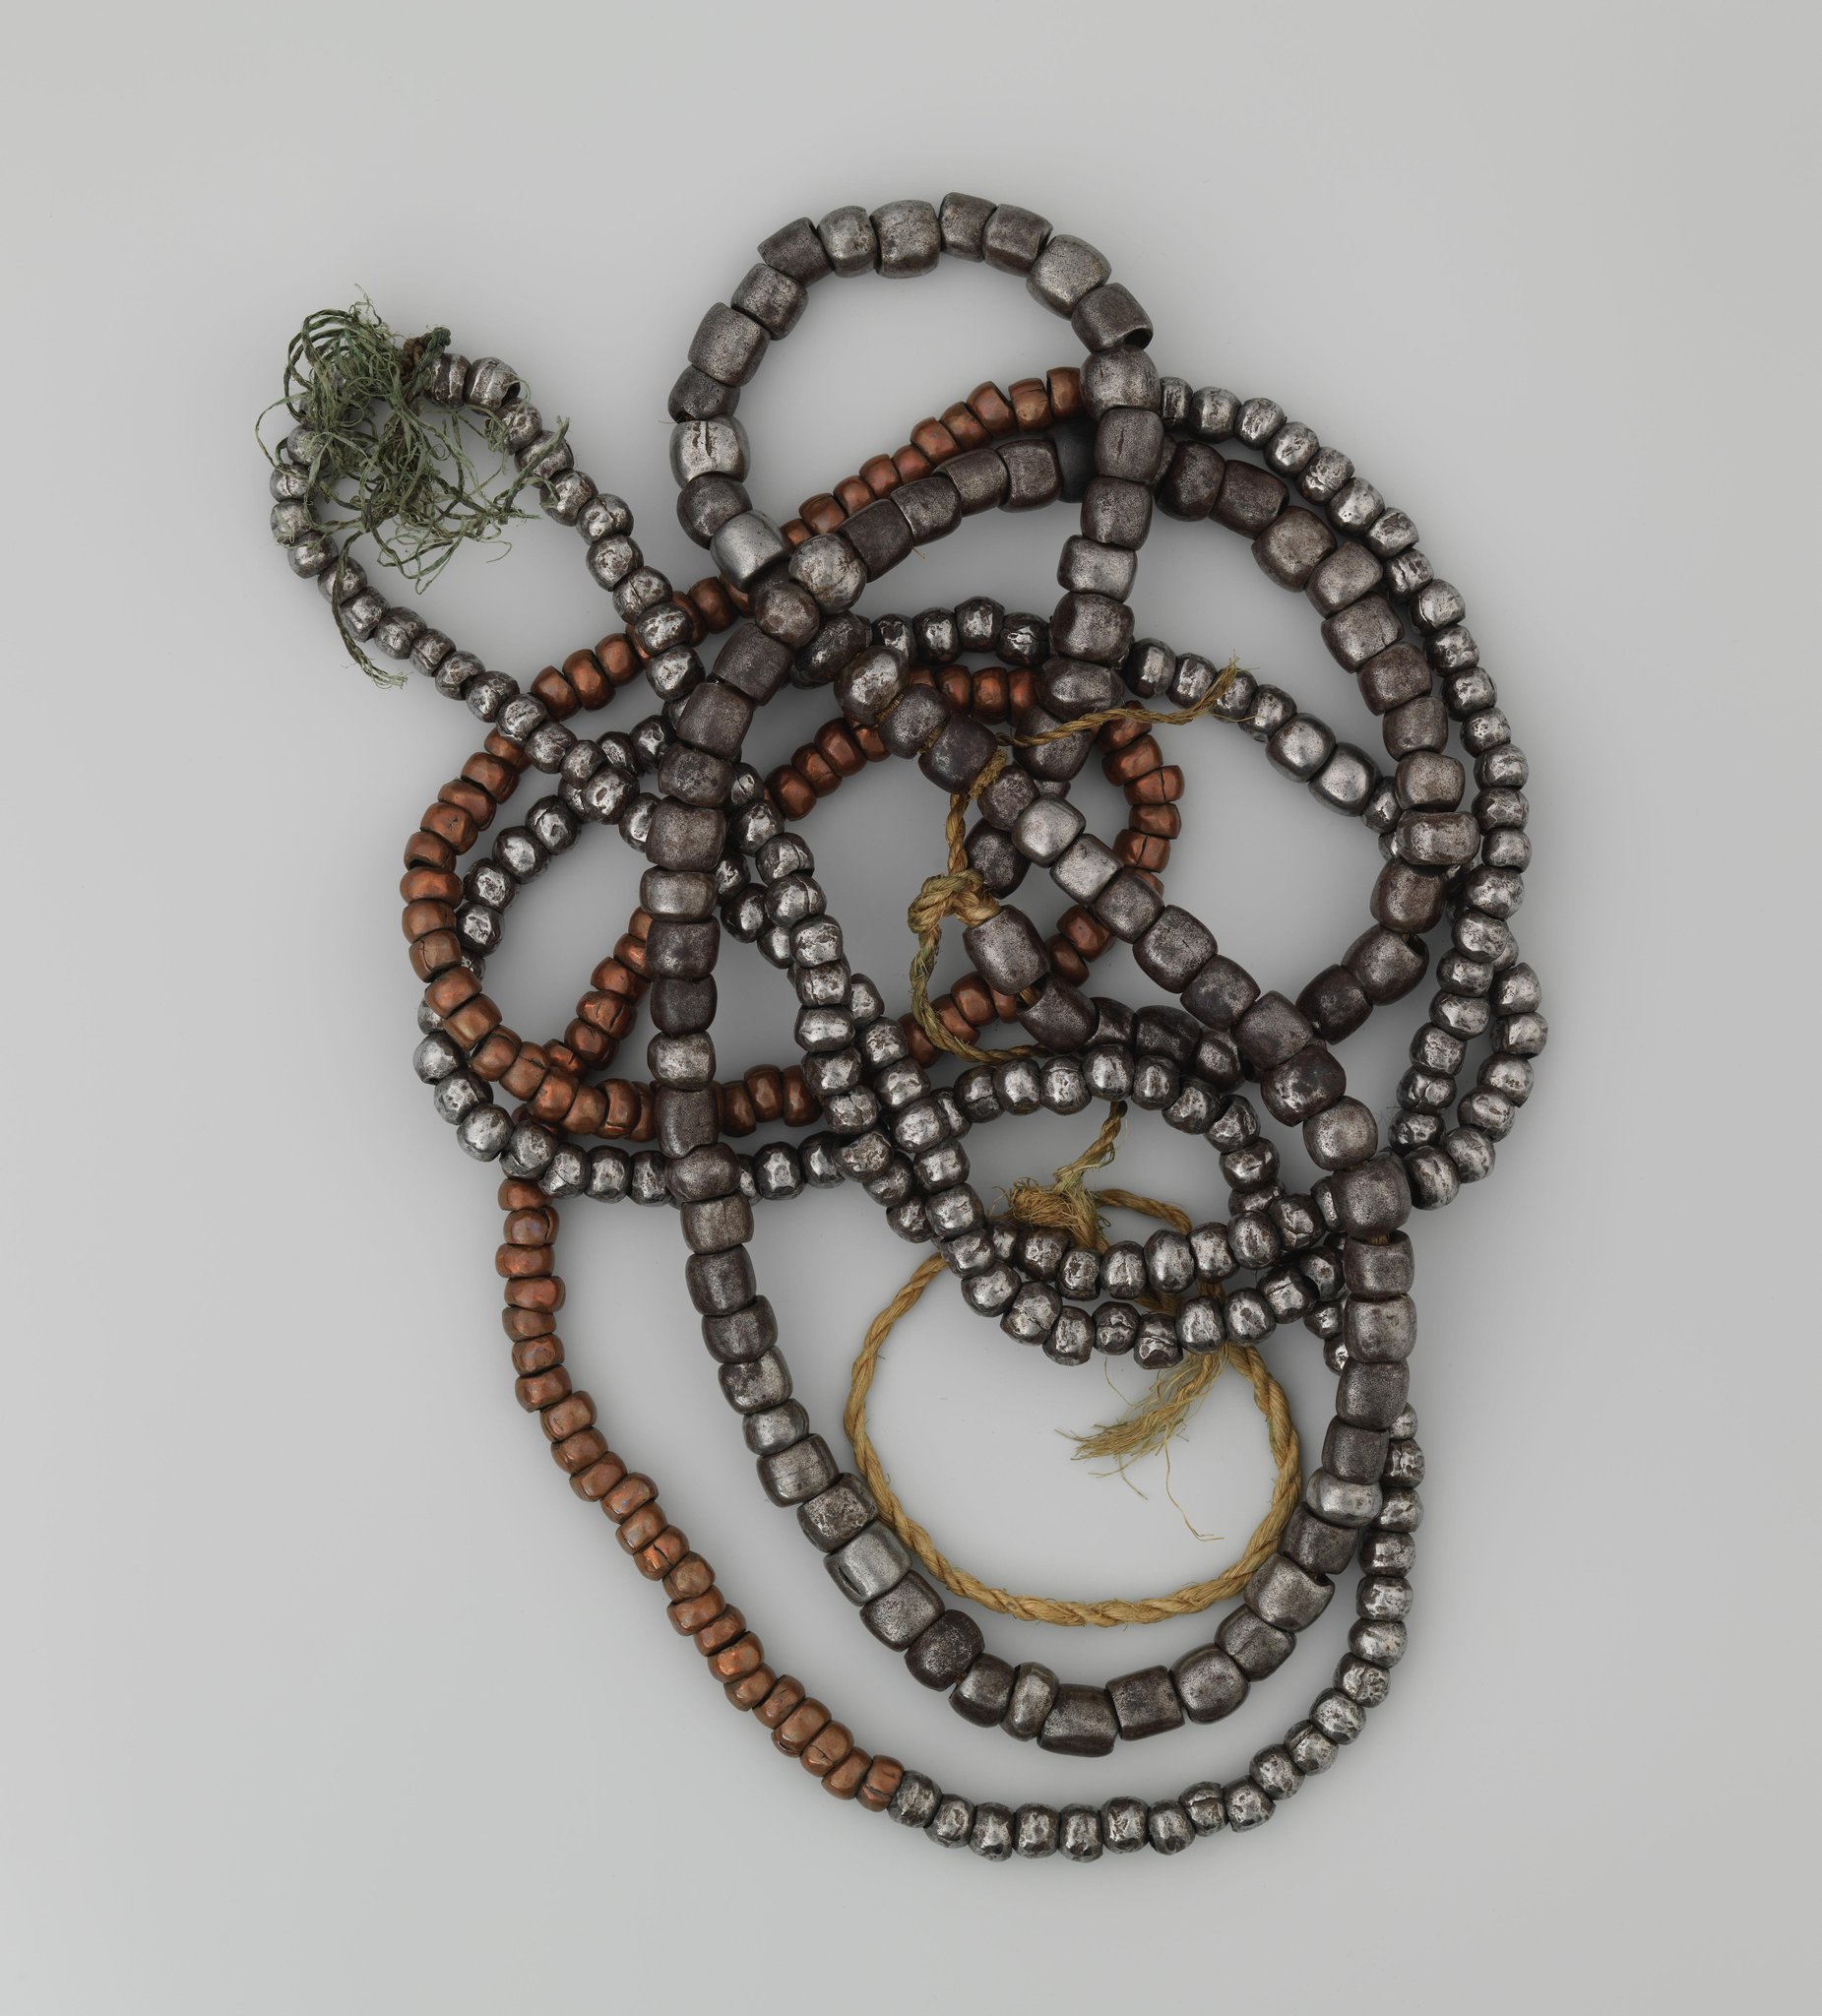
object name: necklace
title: Halssieraad van ijzer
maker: Anonymous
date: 1950-1980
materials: iron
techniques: braiding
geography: kenya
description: Kralen van ijzer aan koord van gevlochten vlas of linnen.